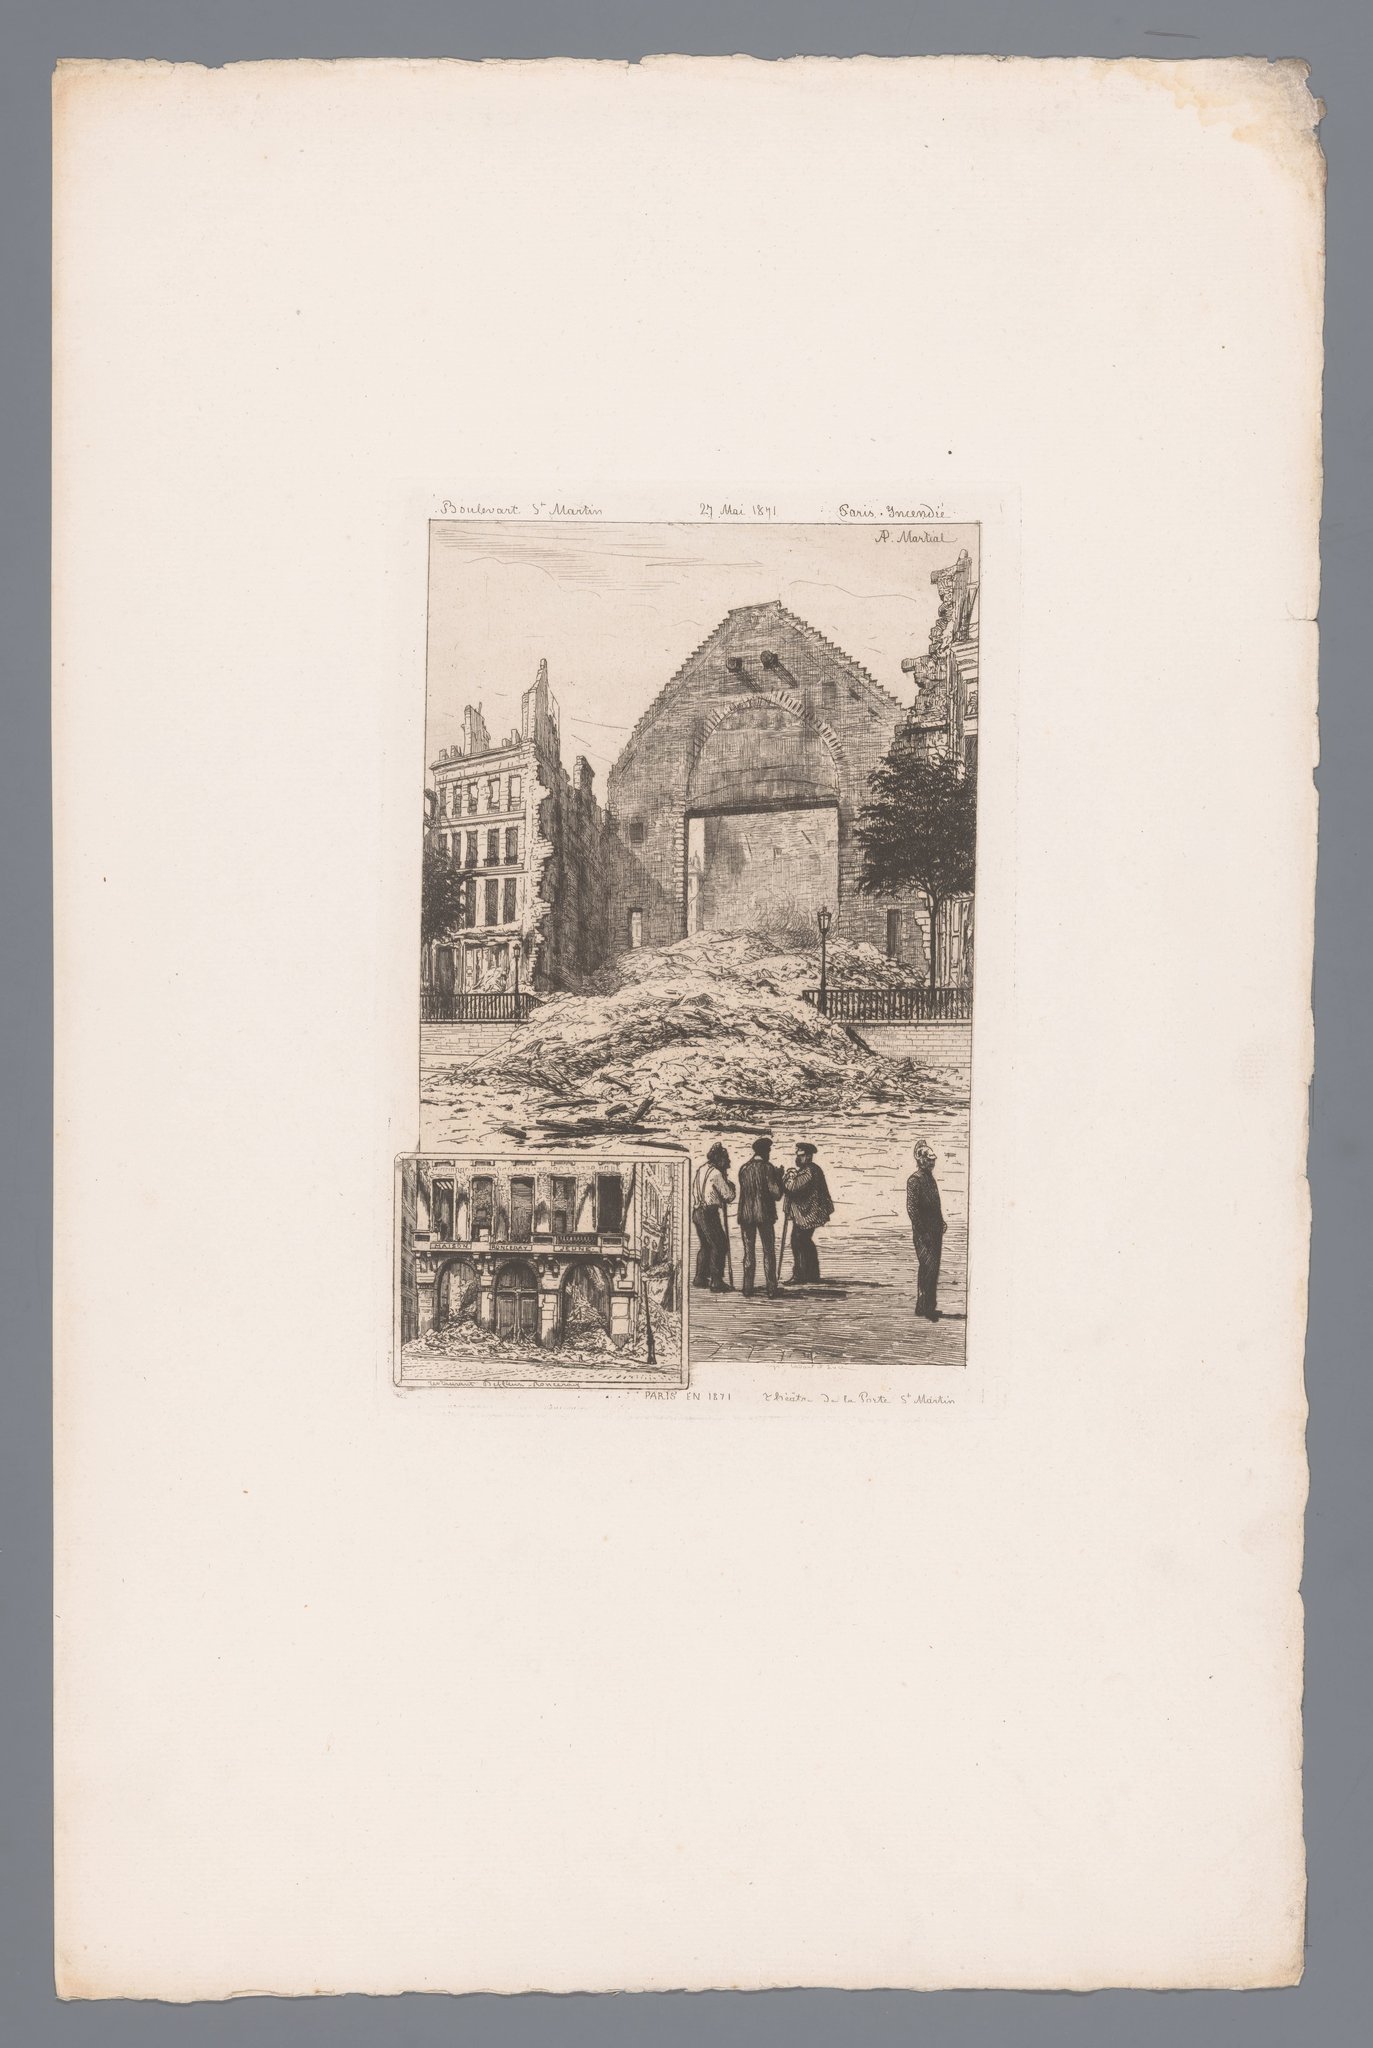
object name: print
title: Parijs in brand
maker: adolphe martial potémont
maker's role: print maker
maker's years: 1828-1883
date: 1871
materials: paper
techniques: etching, intaglio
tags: ruin of a building ~ architecture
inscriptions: collector's mark: Lugt 2228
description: De prent bevindt zich in een omslag en maakt deel uit van een twaalfdelige serie prenten met als onderwerp het brandende Parijs tijdens de Commune in 1871, samengesteld en uitgevoerd door Martial Potémont.